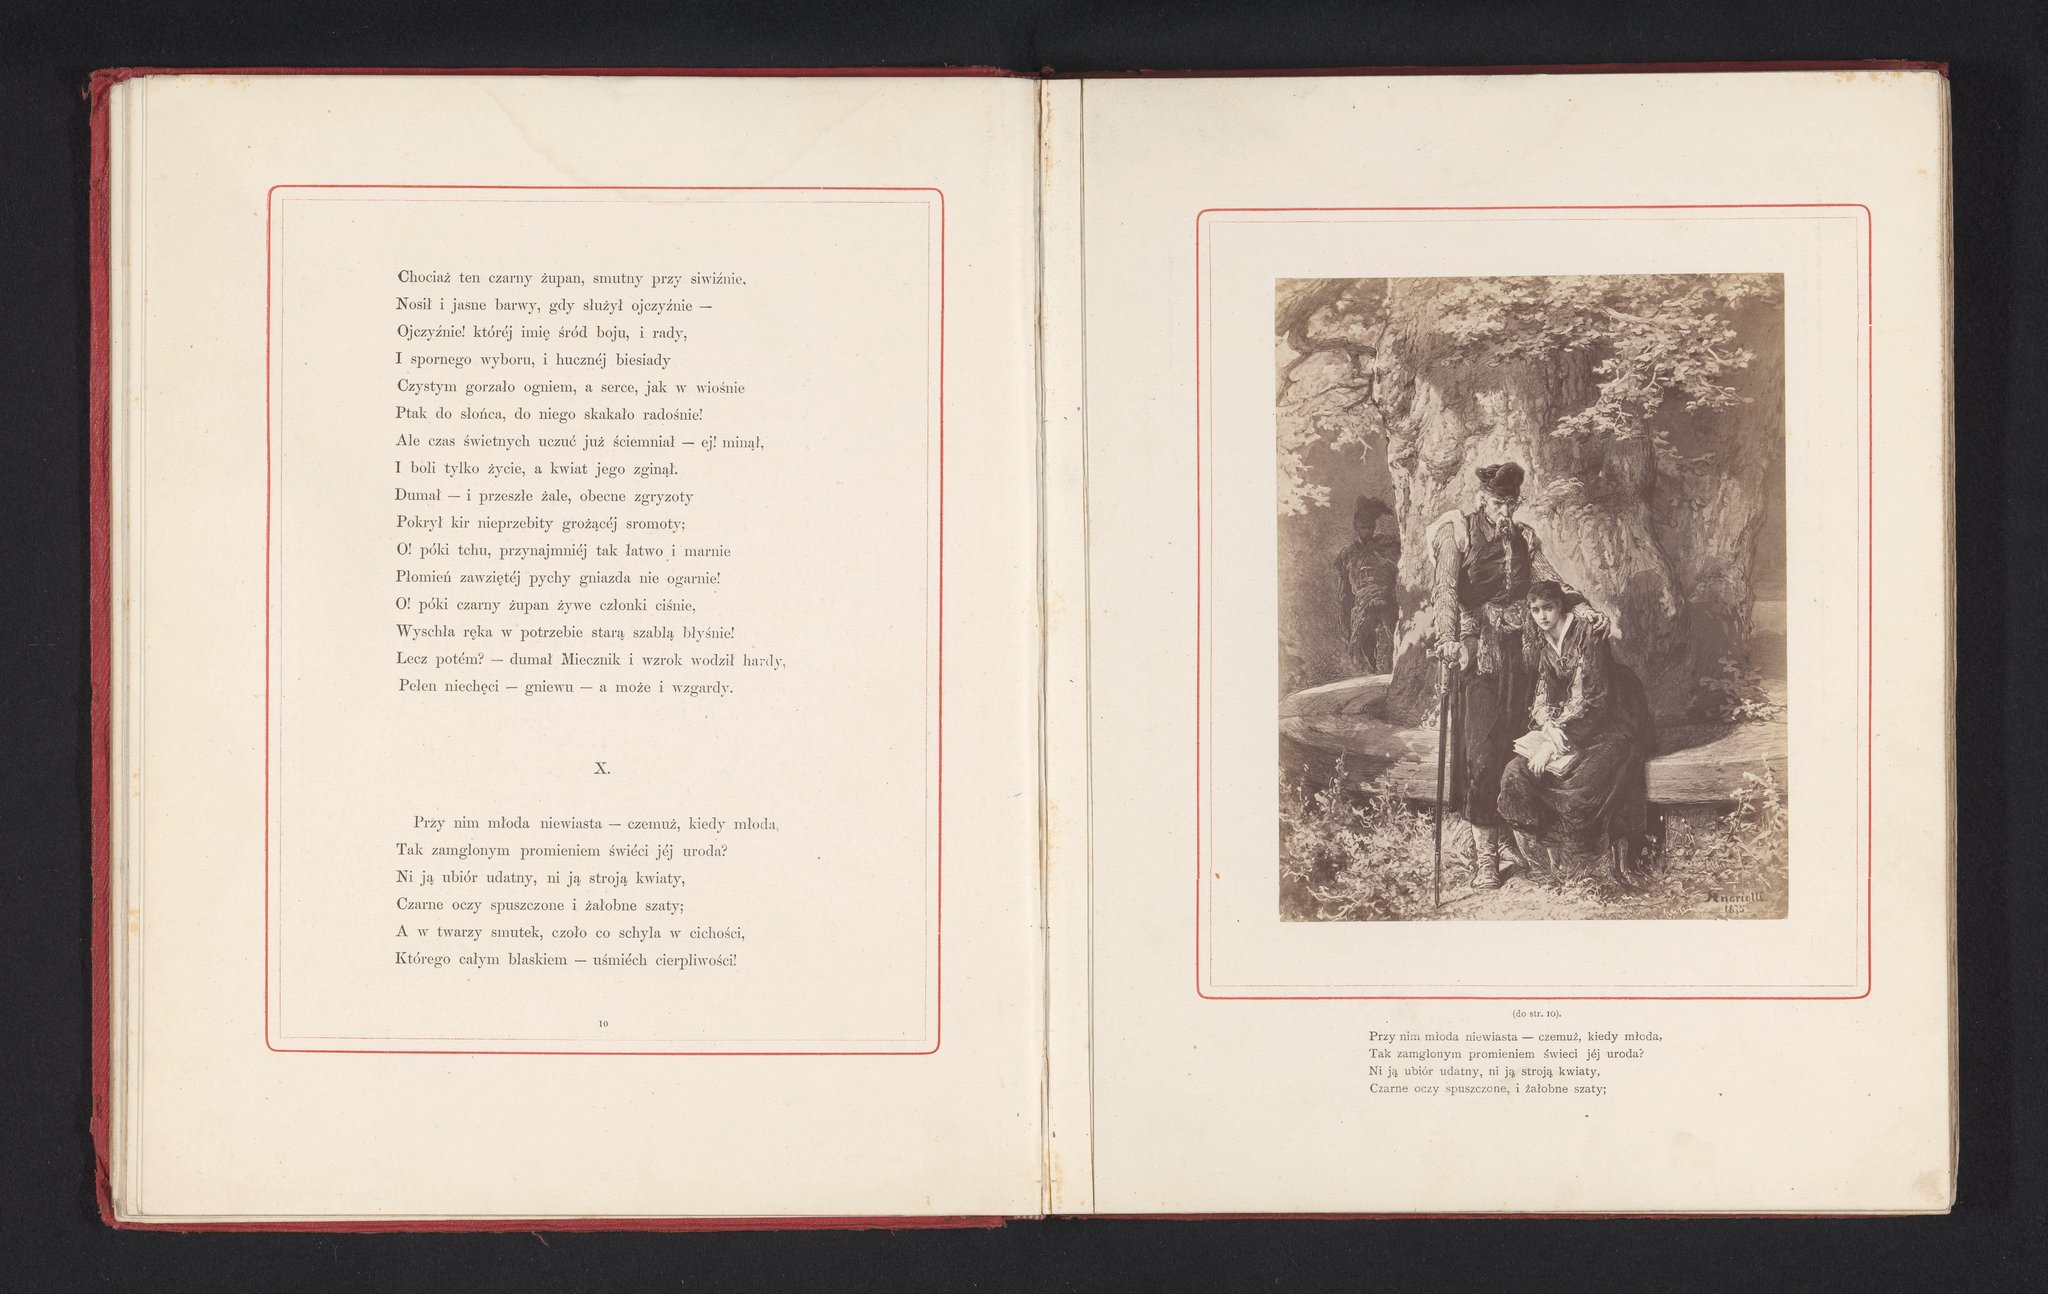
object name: photograph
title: Fotoreproductie van een schilderij voorstellende een oude man bij een vrouw die met een boek voor een boom zit, achter de boom kijkt een man toe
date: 1875-1876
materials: photographic support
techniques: albumen print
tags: trees, reading, old man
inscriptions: inscription: ‘(so stra. 10). Przy nim młoda niewiasta - czemuż, kiedy młoda, Tak zamglonym promieniem świeci jéj uroda? Ni ją ubiór udatny, ni ją stroją kwiaty, Czarne oczy spuszczone, i żałobne szaty.’